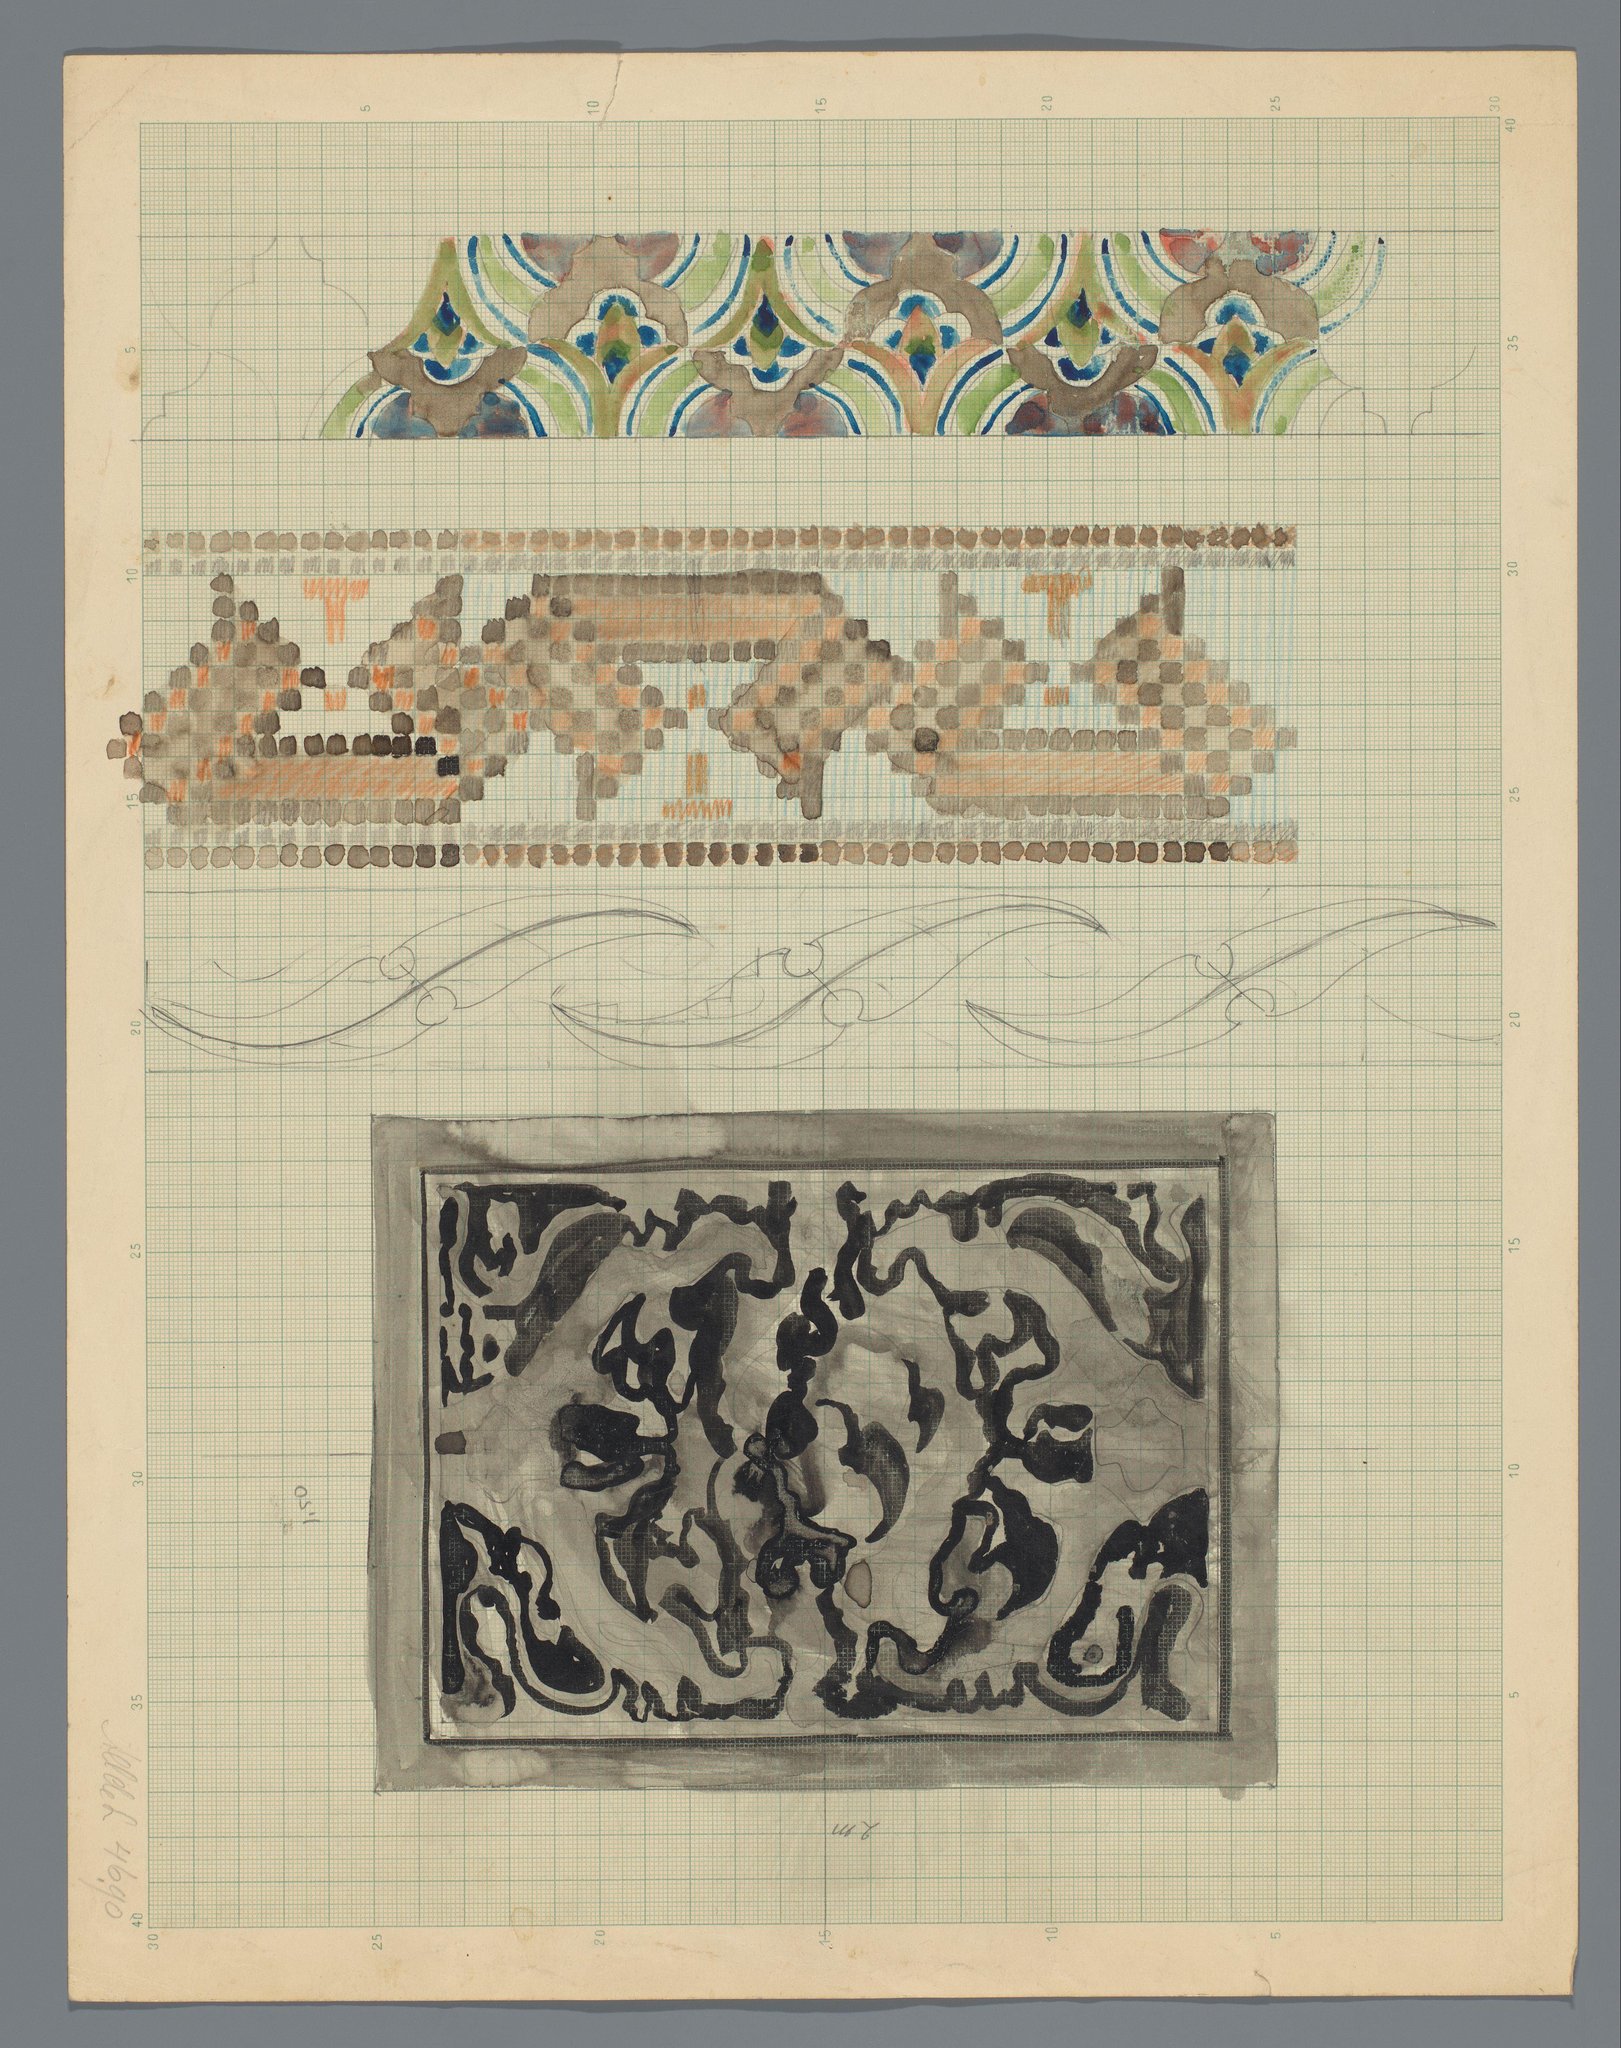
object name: design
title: Ontwerpen voor een kleed met ornamentale randen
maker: carel adolph lion cachet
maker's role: draughtsman, print maker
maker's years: 1864-1945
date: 1874-1945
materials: pencil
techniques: brush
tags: ornaments ~ art, carpet, rug